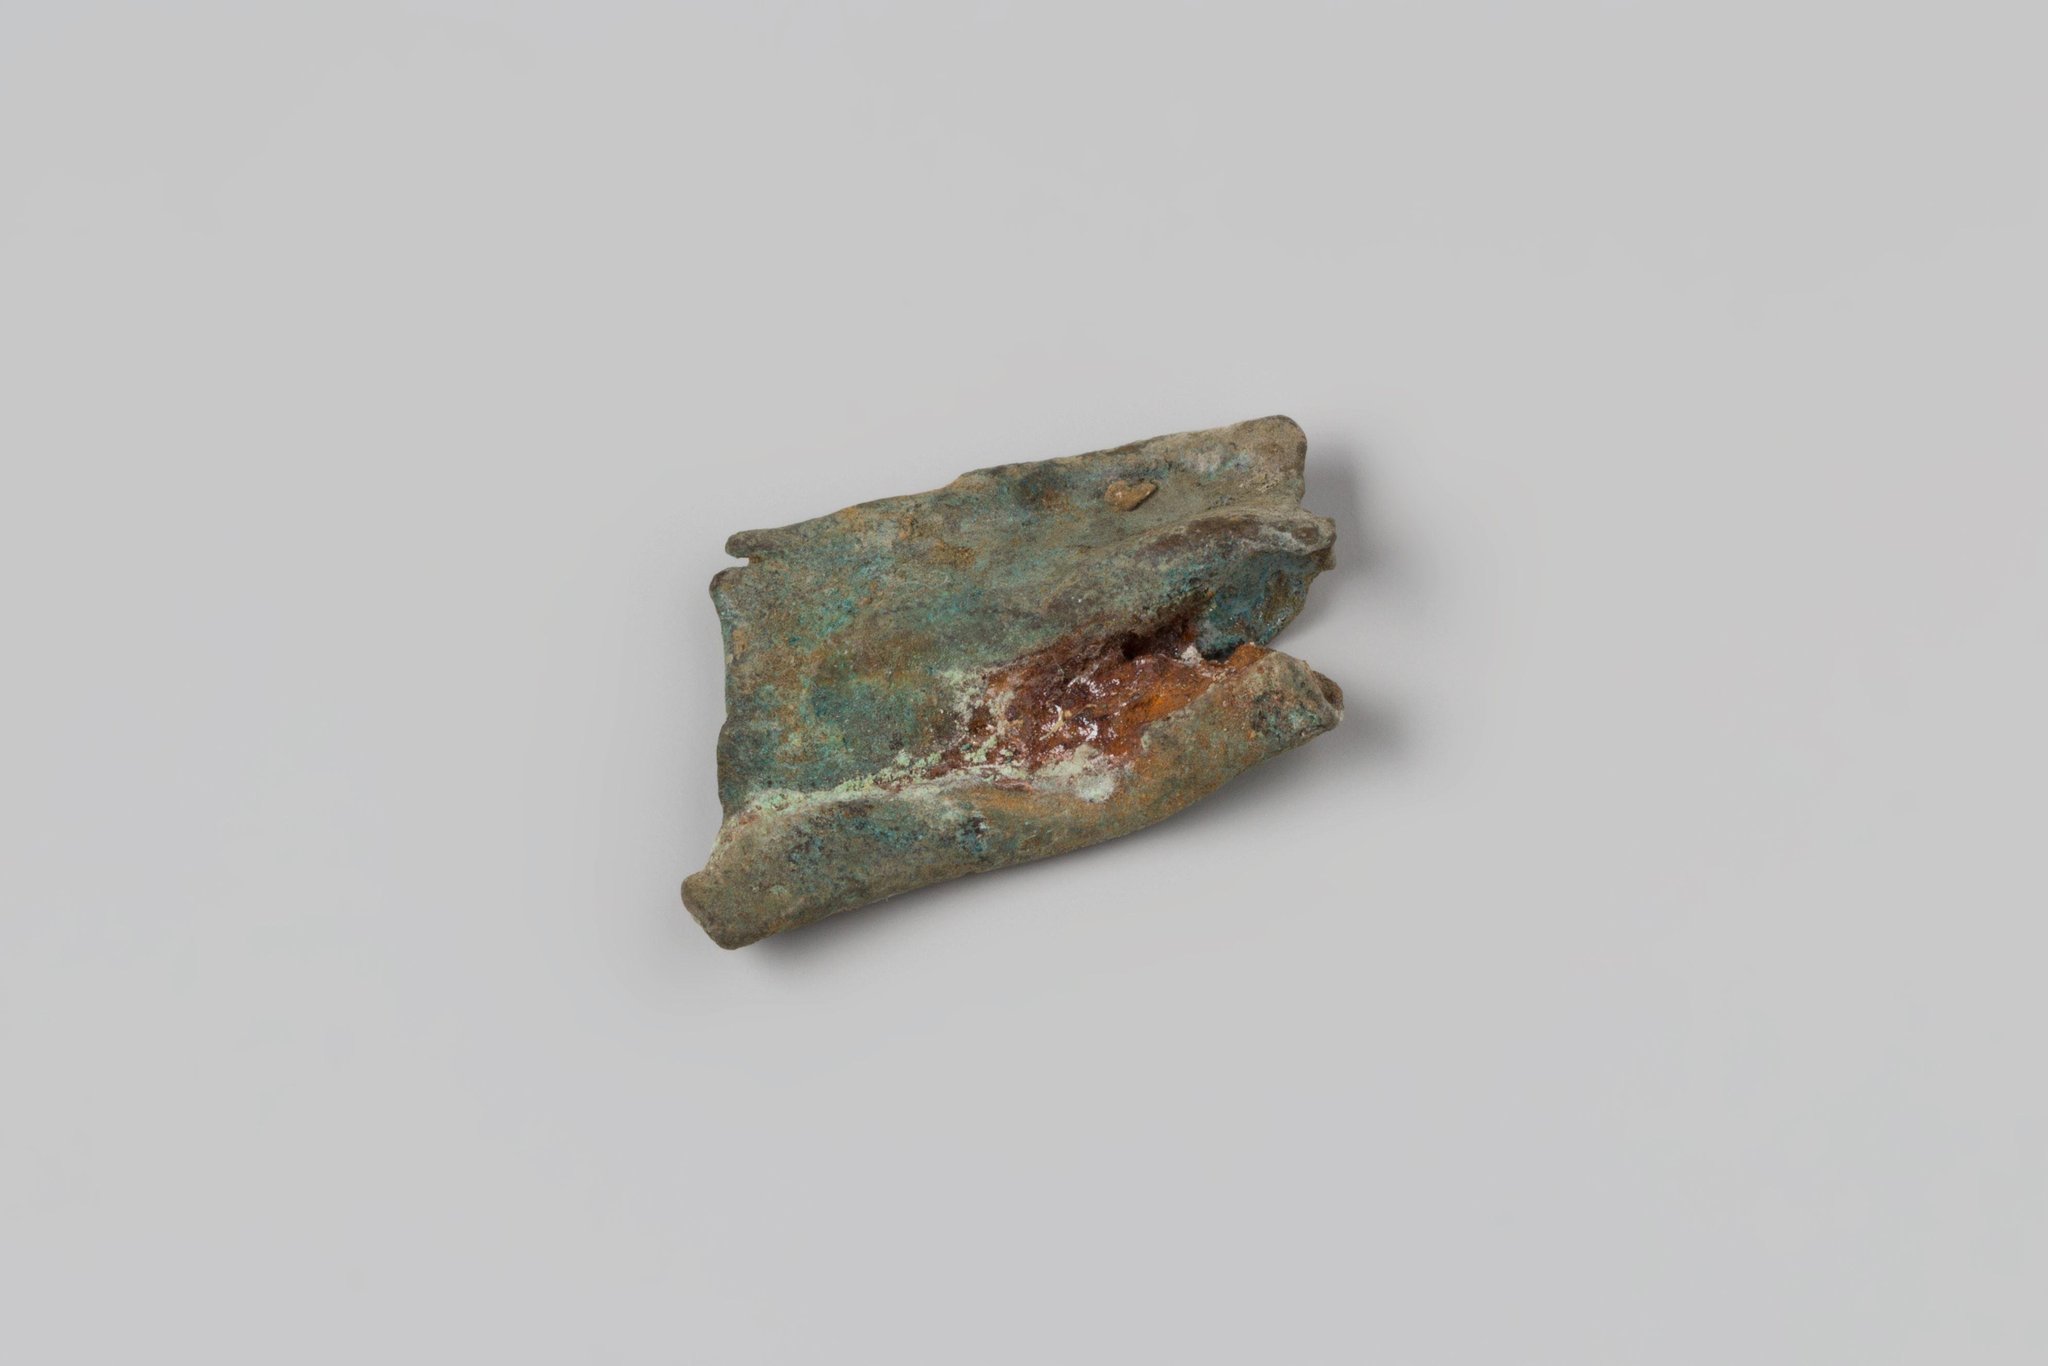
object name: scheepswrakvondst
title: Fragment van koper uit het wrak van de Oost-Indiëvaarder Hollandia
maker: Anonymous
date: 1700-1743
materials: copper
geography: netherlands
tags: verenigde oostindische compagnie, hollandia (schip), annet